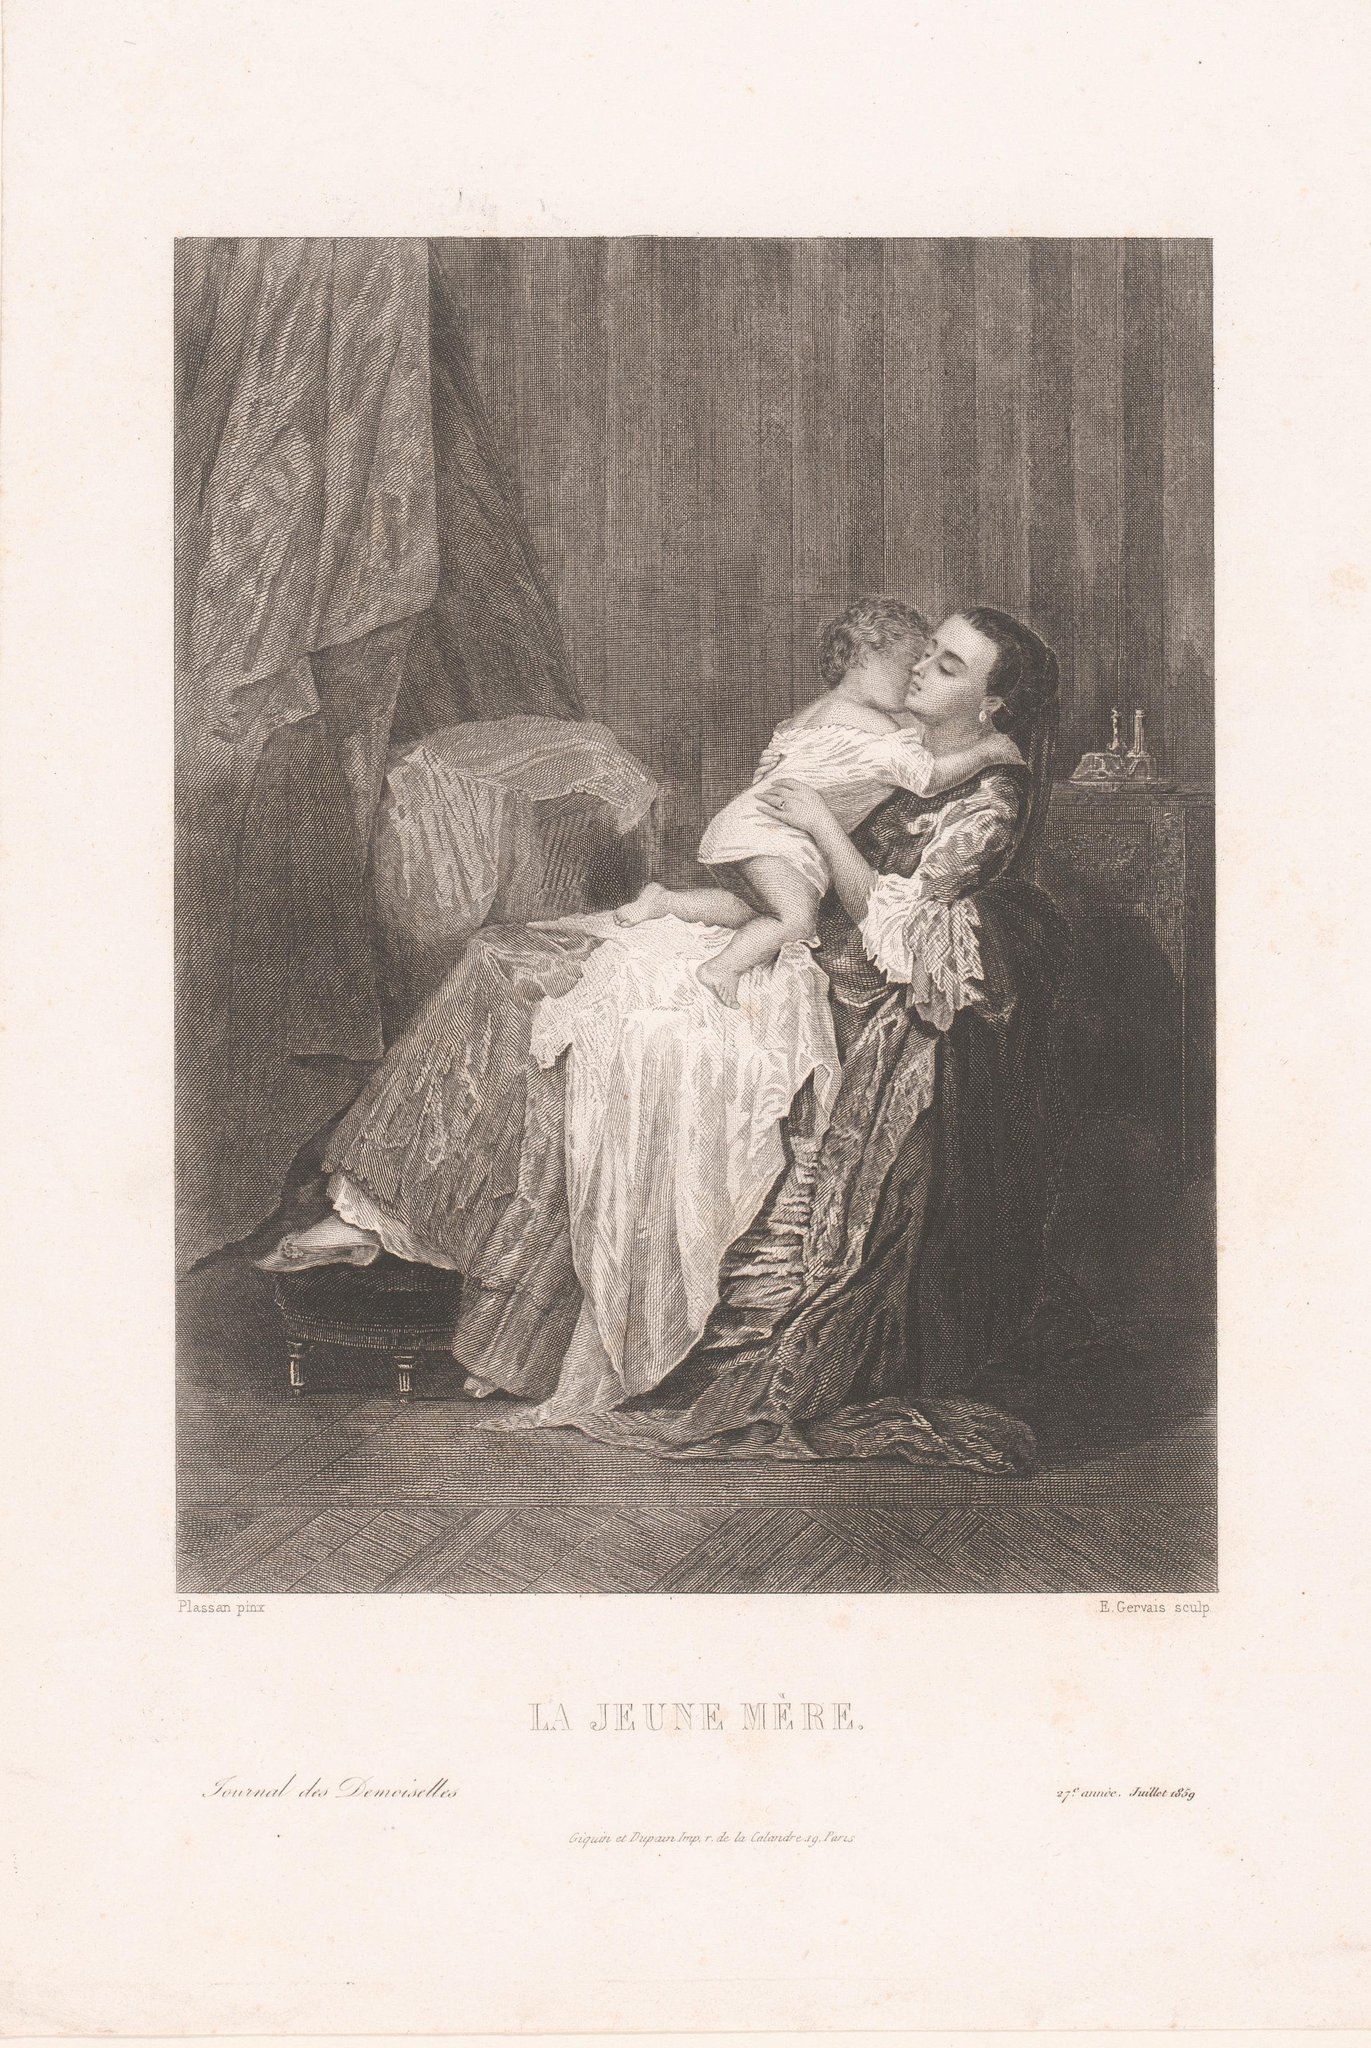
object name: print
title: Moeder met kind in een slaapkamer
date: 1856-1859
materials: paper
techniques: etching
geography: paris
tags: mother and baby or young child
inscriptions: collector's mark: Lugt 2228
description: Gepubliceerd in 'Journal des Desmoiselles', juli 1859.